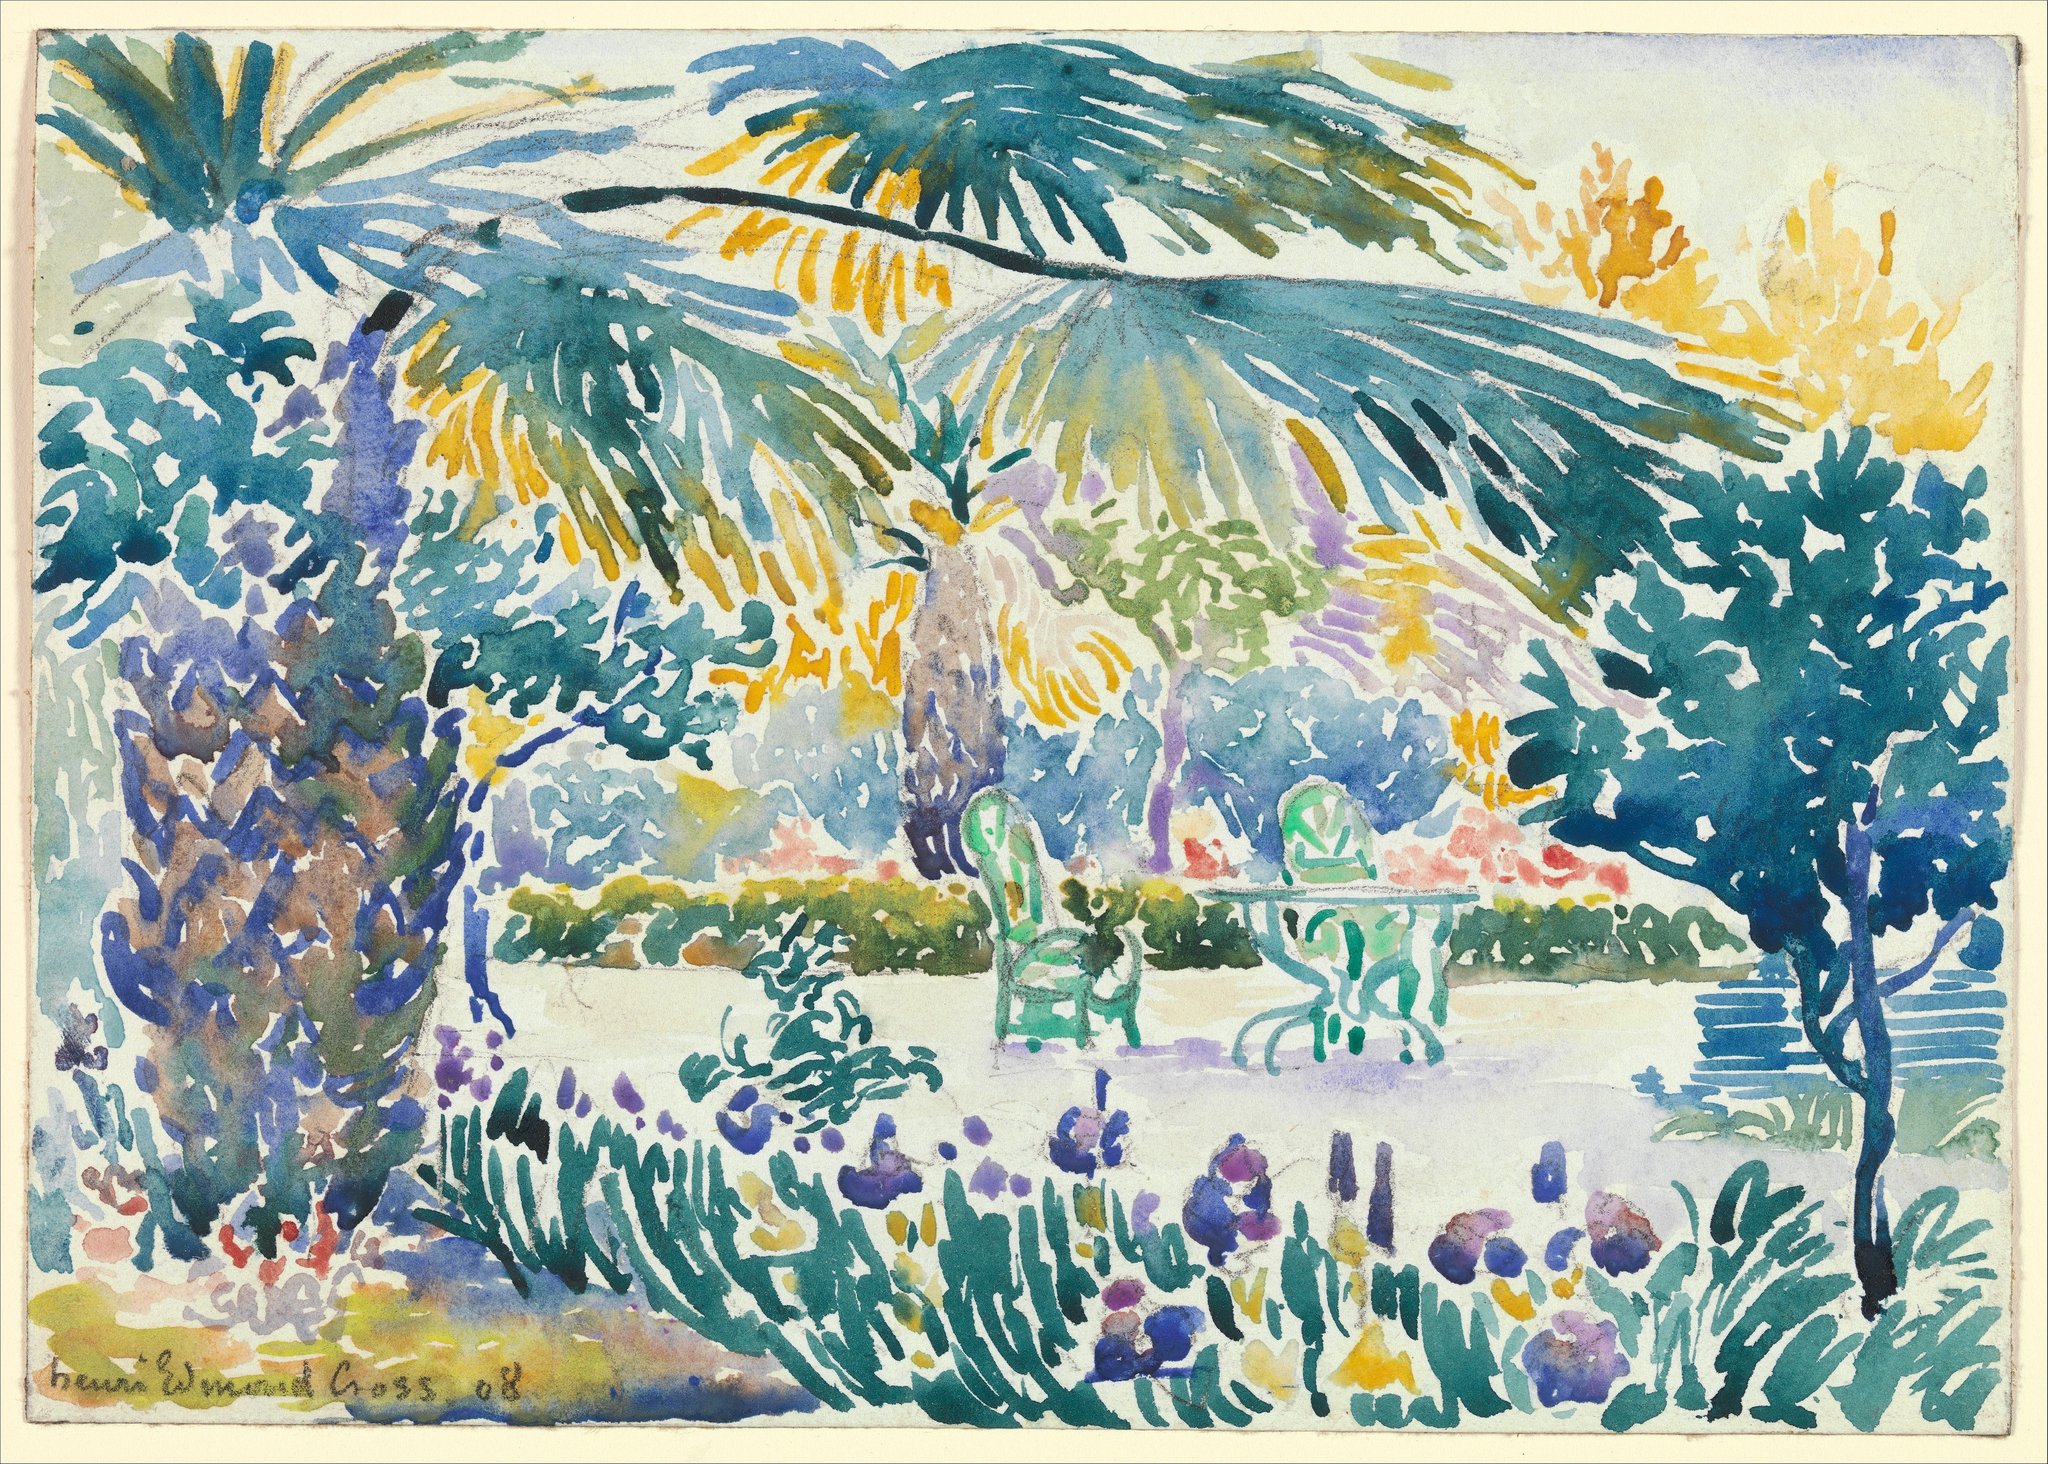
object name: drawing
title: Garden of the Painter at Saint Clair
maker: henri-edmond cross (henri-edmond delacroix)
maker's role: artist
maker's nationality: french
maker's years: 1856-1910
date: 1908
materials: graphite, watercolor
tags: gardens,landscapes